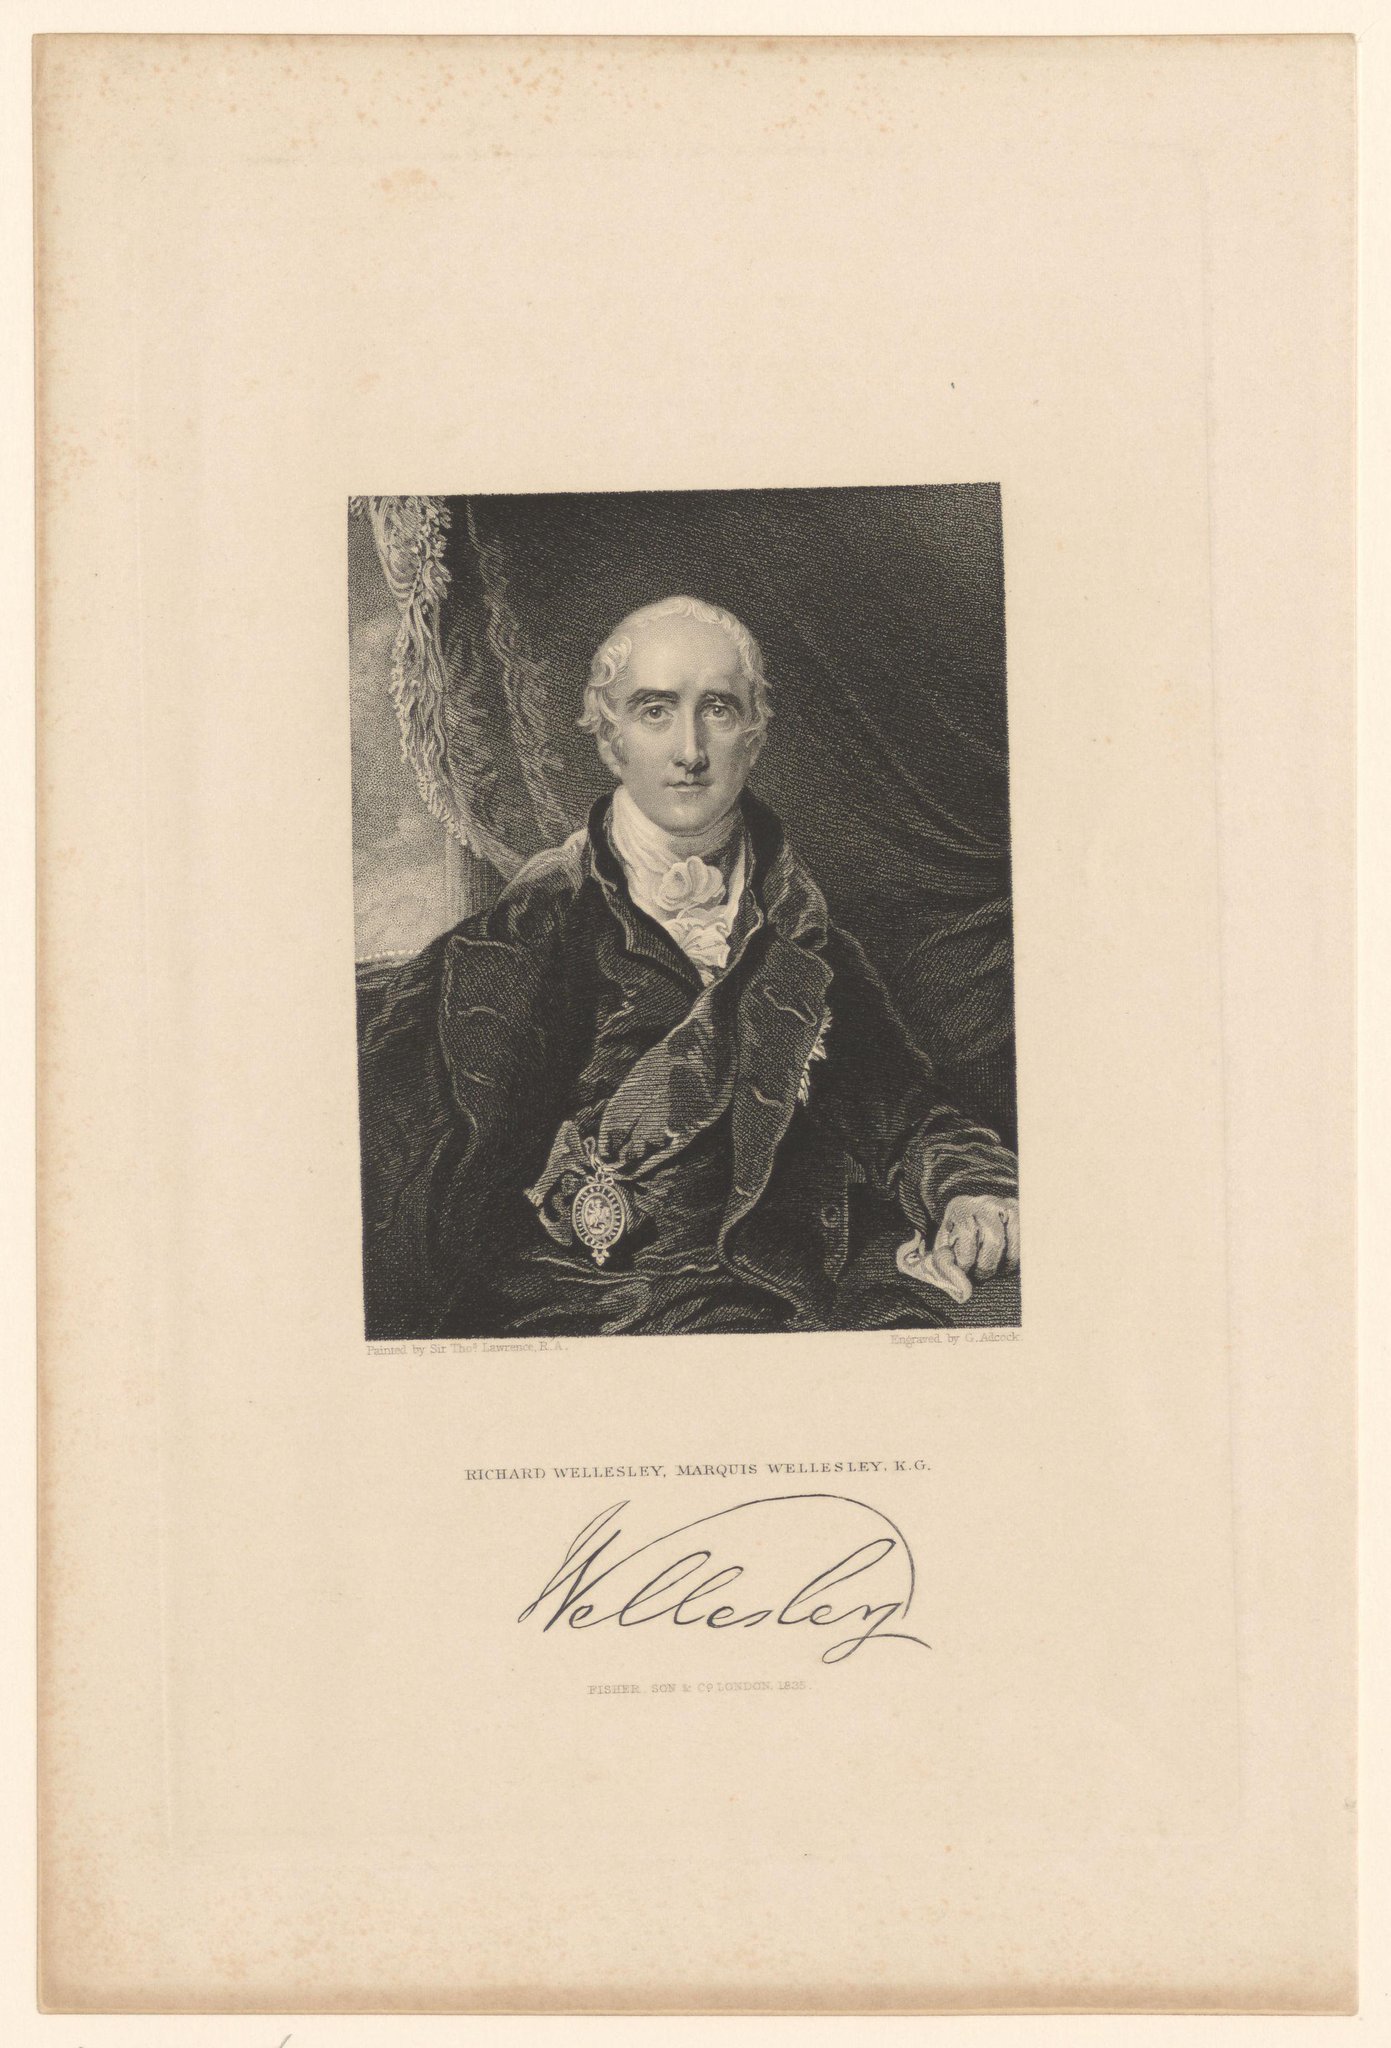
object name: print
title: Richard Wellesley, Marquis Wellesley, K.G.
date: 1835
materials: paper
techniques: engraving, etching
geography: london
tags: historical persons, politician, e.g. party leader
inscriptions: collector's mark: Lugt 2228